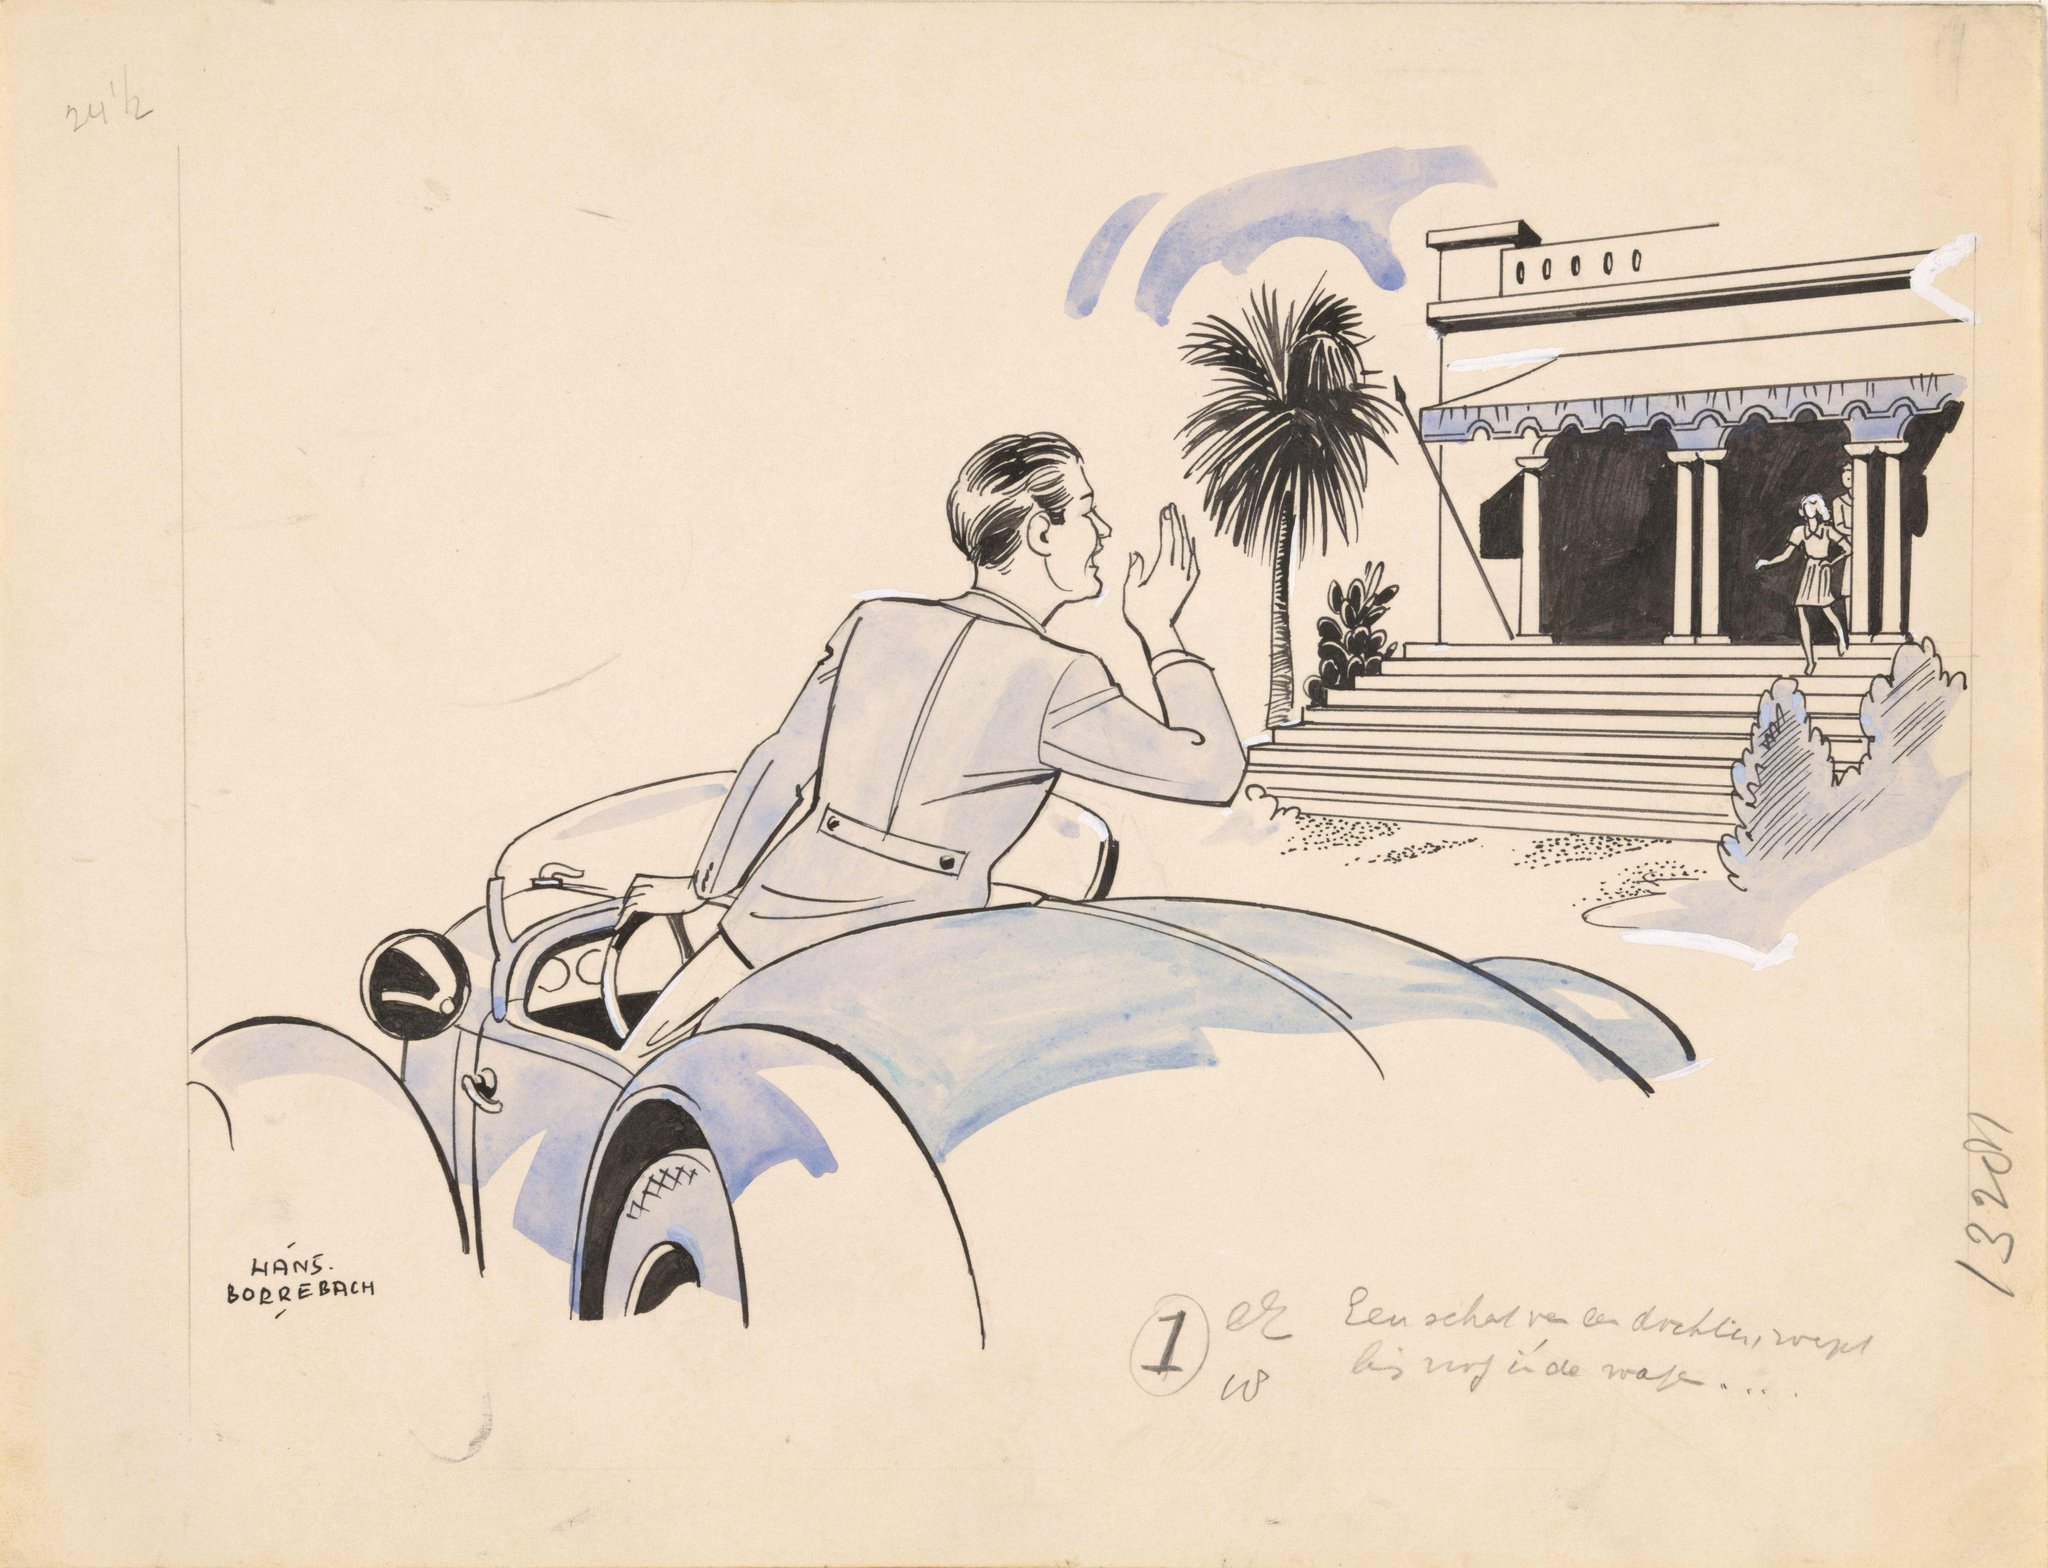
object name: boekillustratie ontwerp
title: Man zwaait naar een vrouw vanuit een auto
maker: hans borrebach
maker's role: draughtsman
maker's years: 1903-1991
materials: paint, ink, paper, pencil, watercolor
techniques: brush, pen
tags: flight of steps, non-aggressive relationships, automobile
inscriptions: :, collector's mark: Lugt 2228a, annotation: ‘1 bz/ 18/ Een schat van een dochter, roept/ hij nog in de wagen....’, signature: ‘HANS./ BORREBACH’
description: Een man staat rechtop in een auto met open dak. Hij zwaait naar een jonge vrouw die van een trap voor een gebouw komt aflopen. Naast het gebouw staat een palmboom.